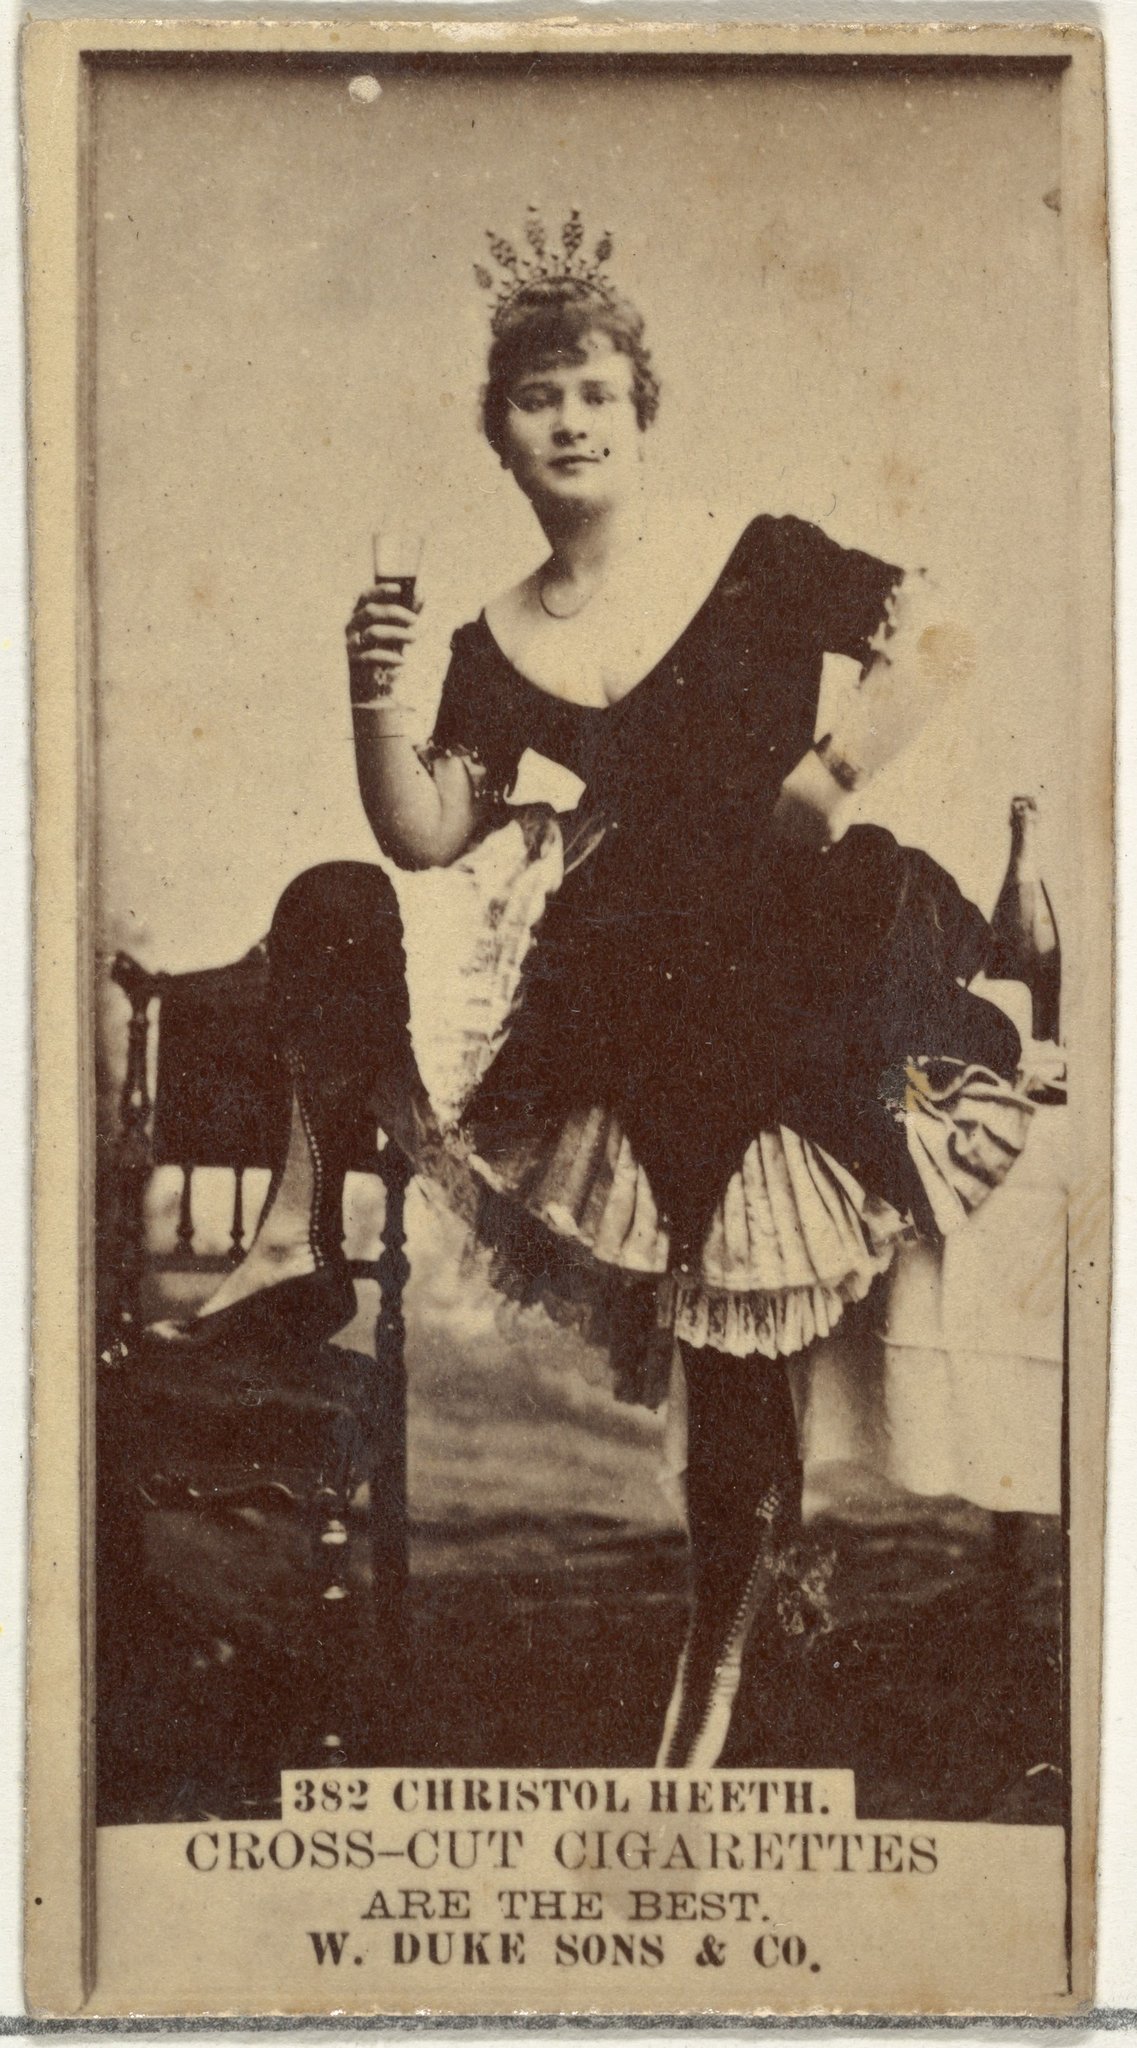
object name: photograph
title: Card Number 382, (Louise Weber), from the Actors and Actresses series (N145-3) issued by Duke Sons & Co. to promote Cross Cut Cigarettes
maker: w. duke, sons & co.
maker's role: publisher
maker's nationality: american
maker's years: 1870-1920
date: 1880-1889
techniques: albumen silver print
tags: portraits,women,actresses